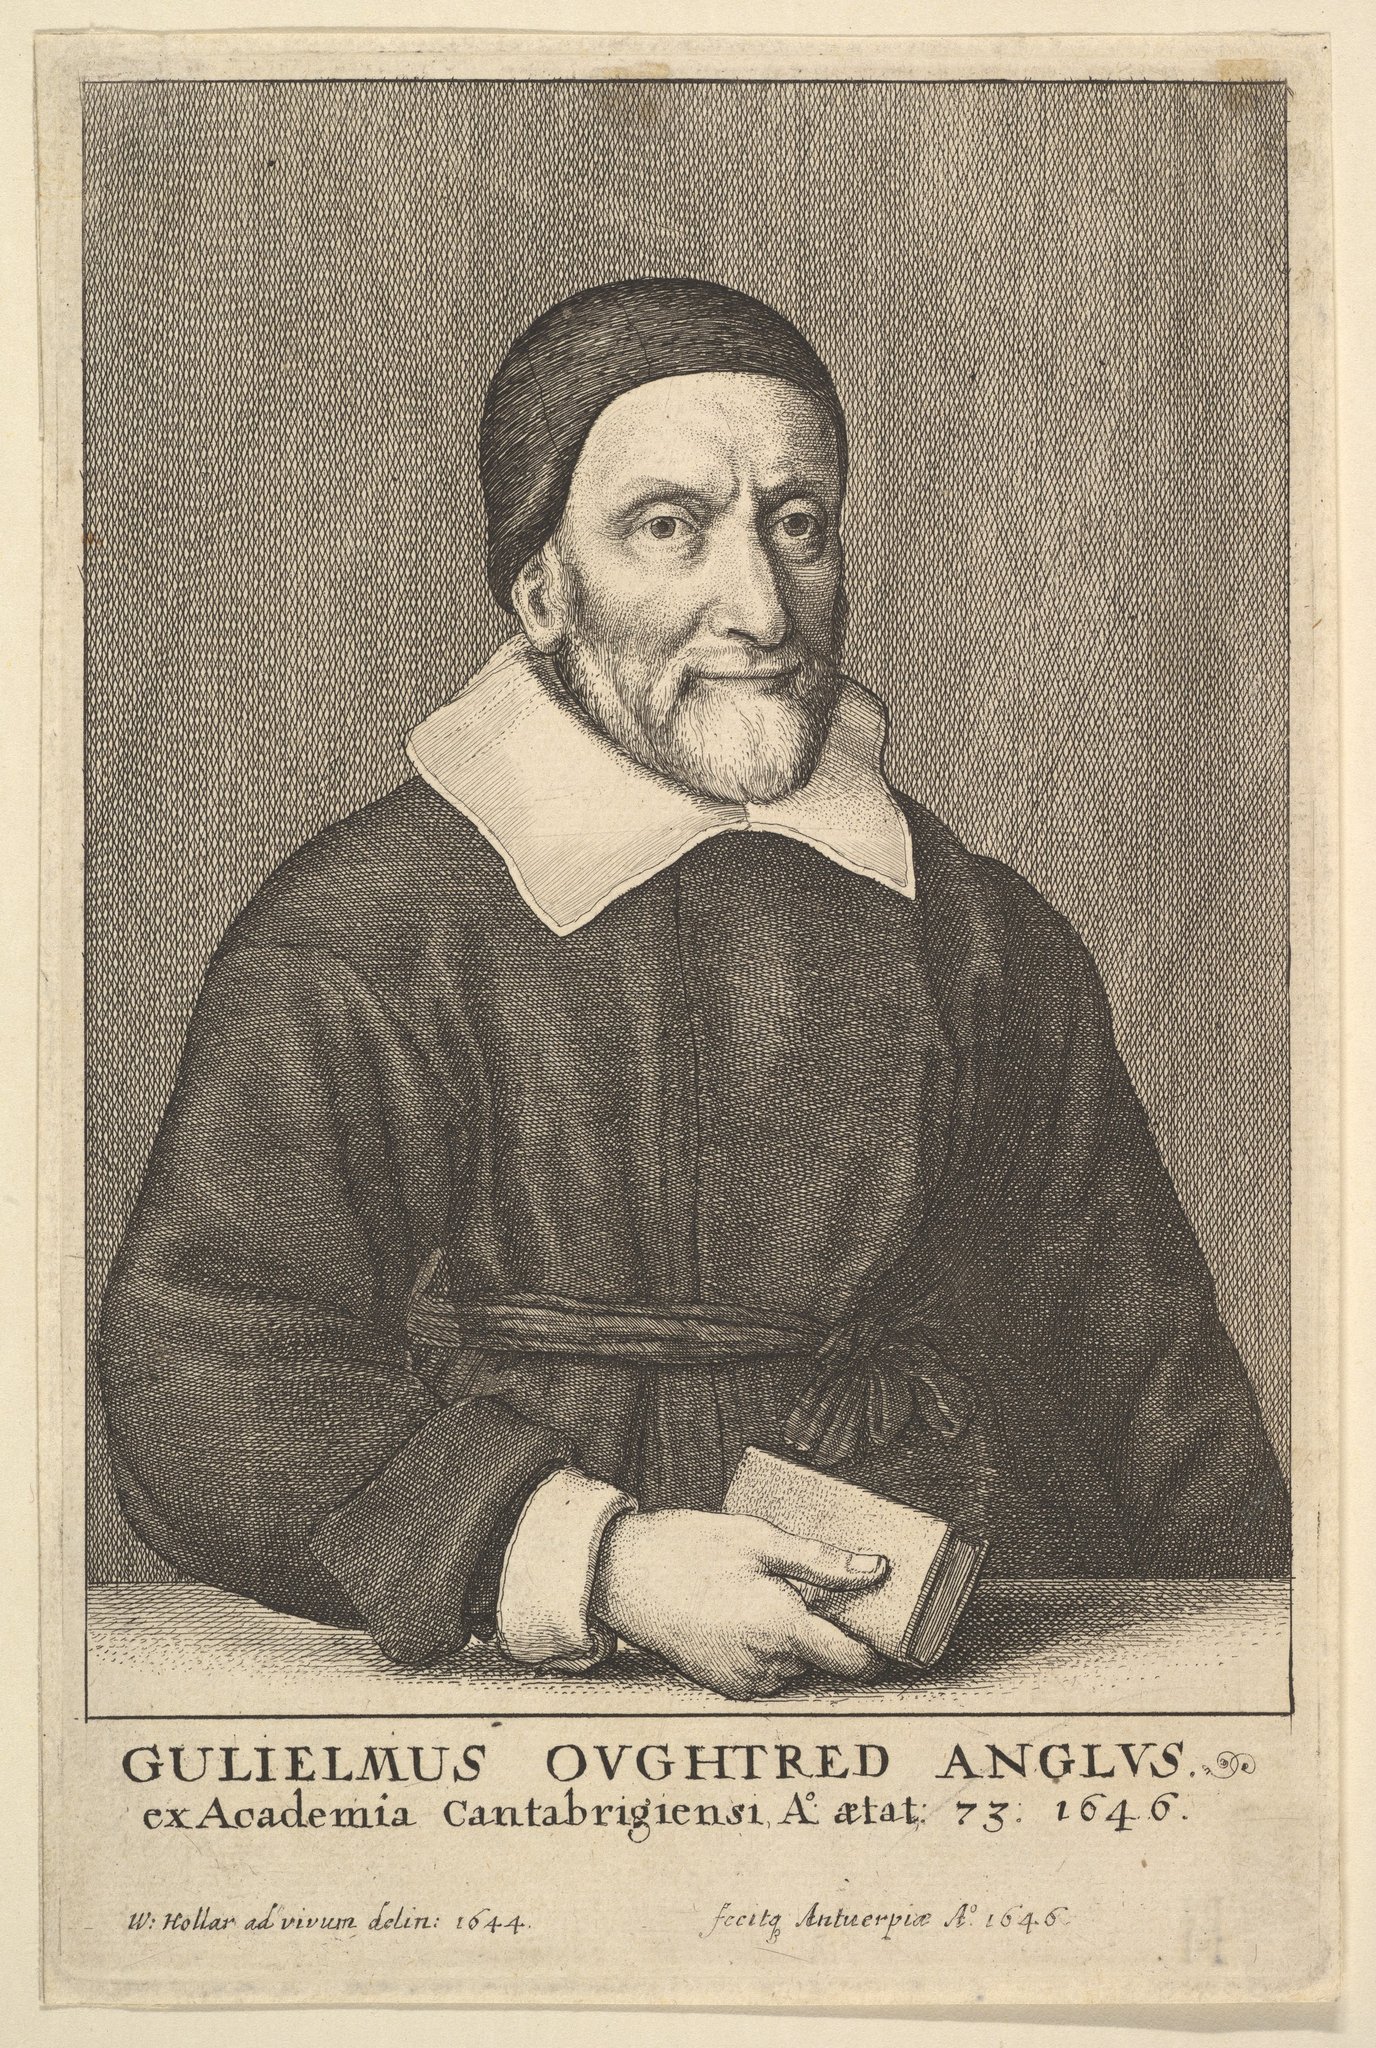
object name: print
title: William Oughtred (frontispiece from William Oughtred's "The Key of the Mathematicks New Forged and Filed," 1647)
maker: wenceslaus hollar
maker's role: artist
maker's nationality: bohemian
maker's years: 1607-1677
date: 1644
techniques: drypoint, etching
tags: men,portraits